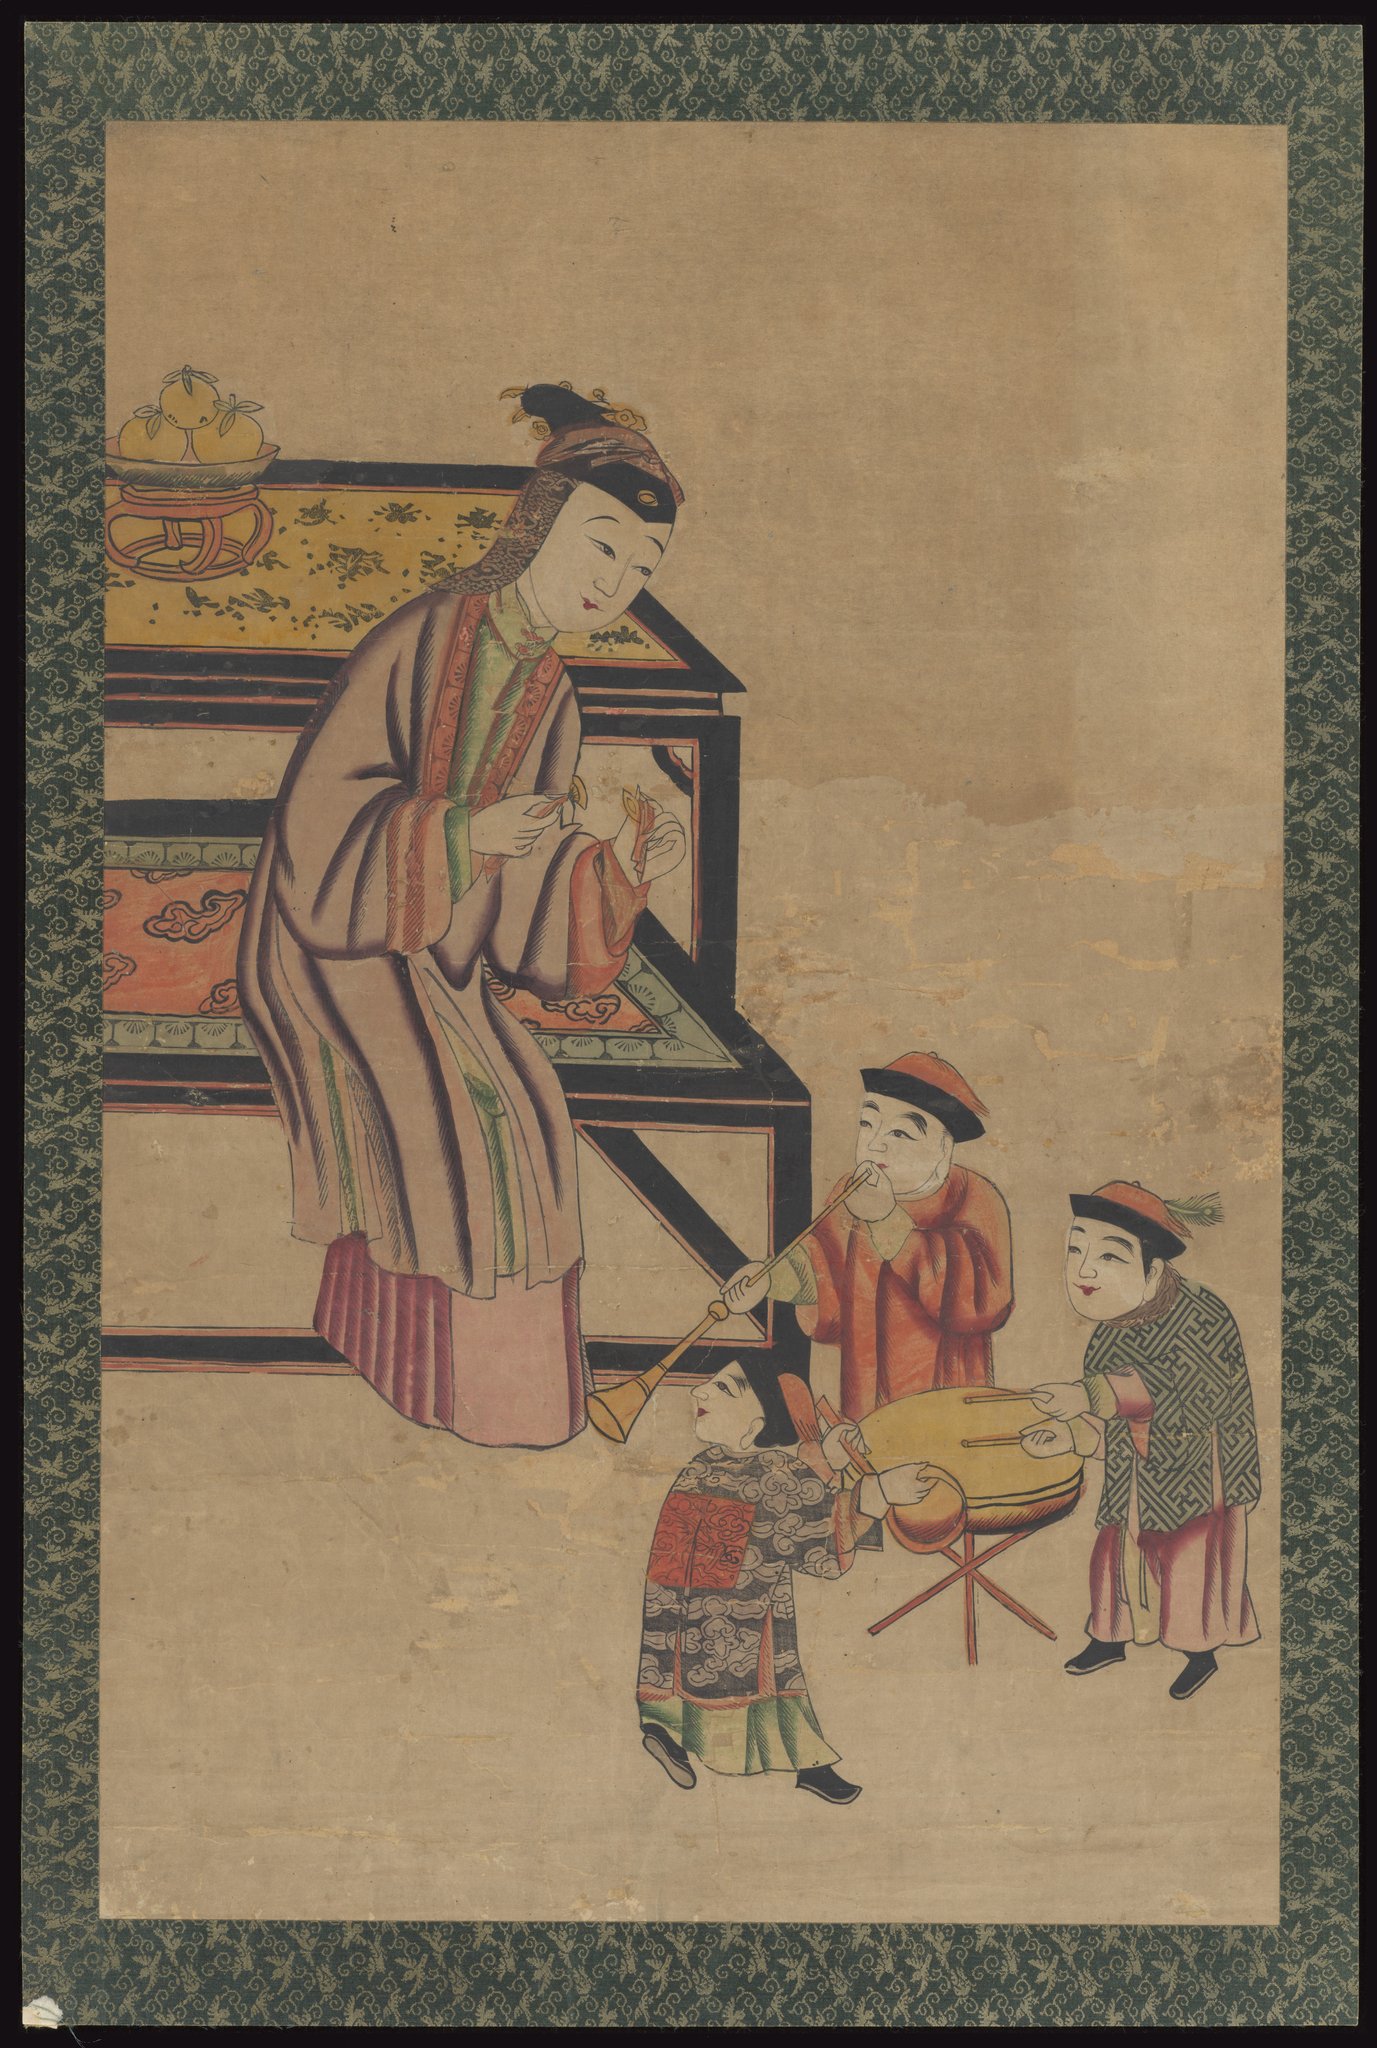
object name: print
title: Lady with Boys Playing Instruments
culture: chinese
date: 1736-1795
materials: ink, paper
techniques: hand coloring, woodblock print